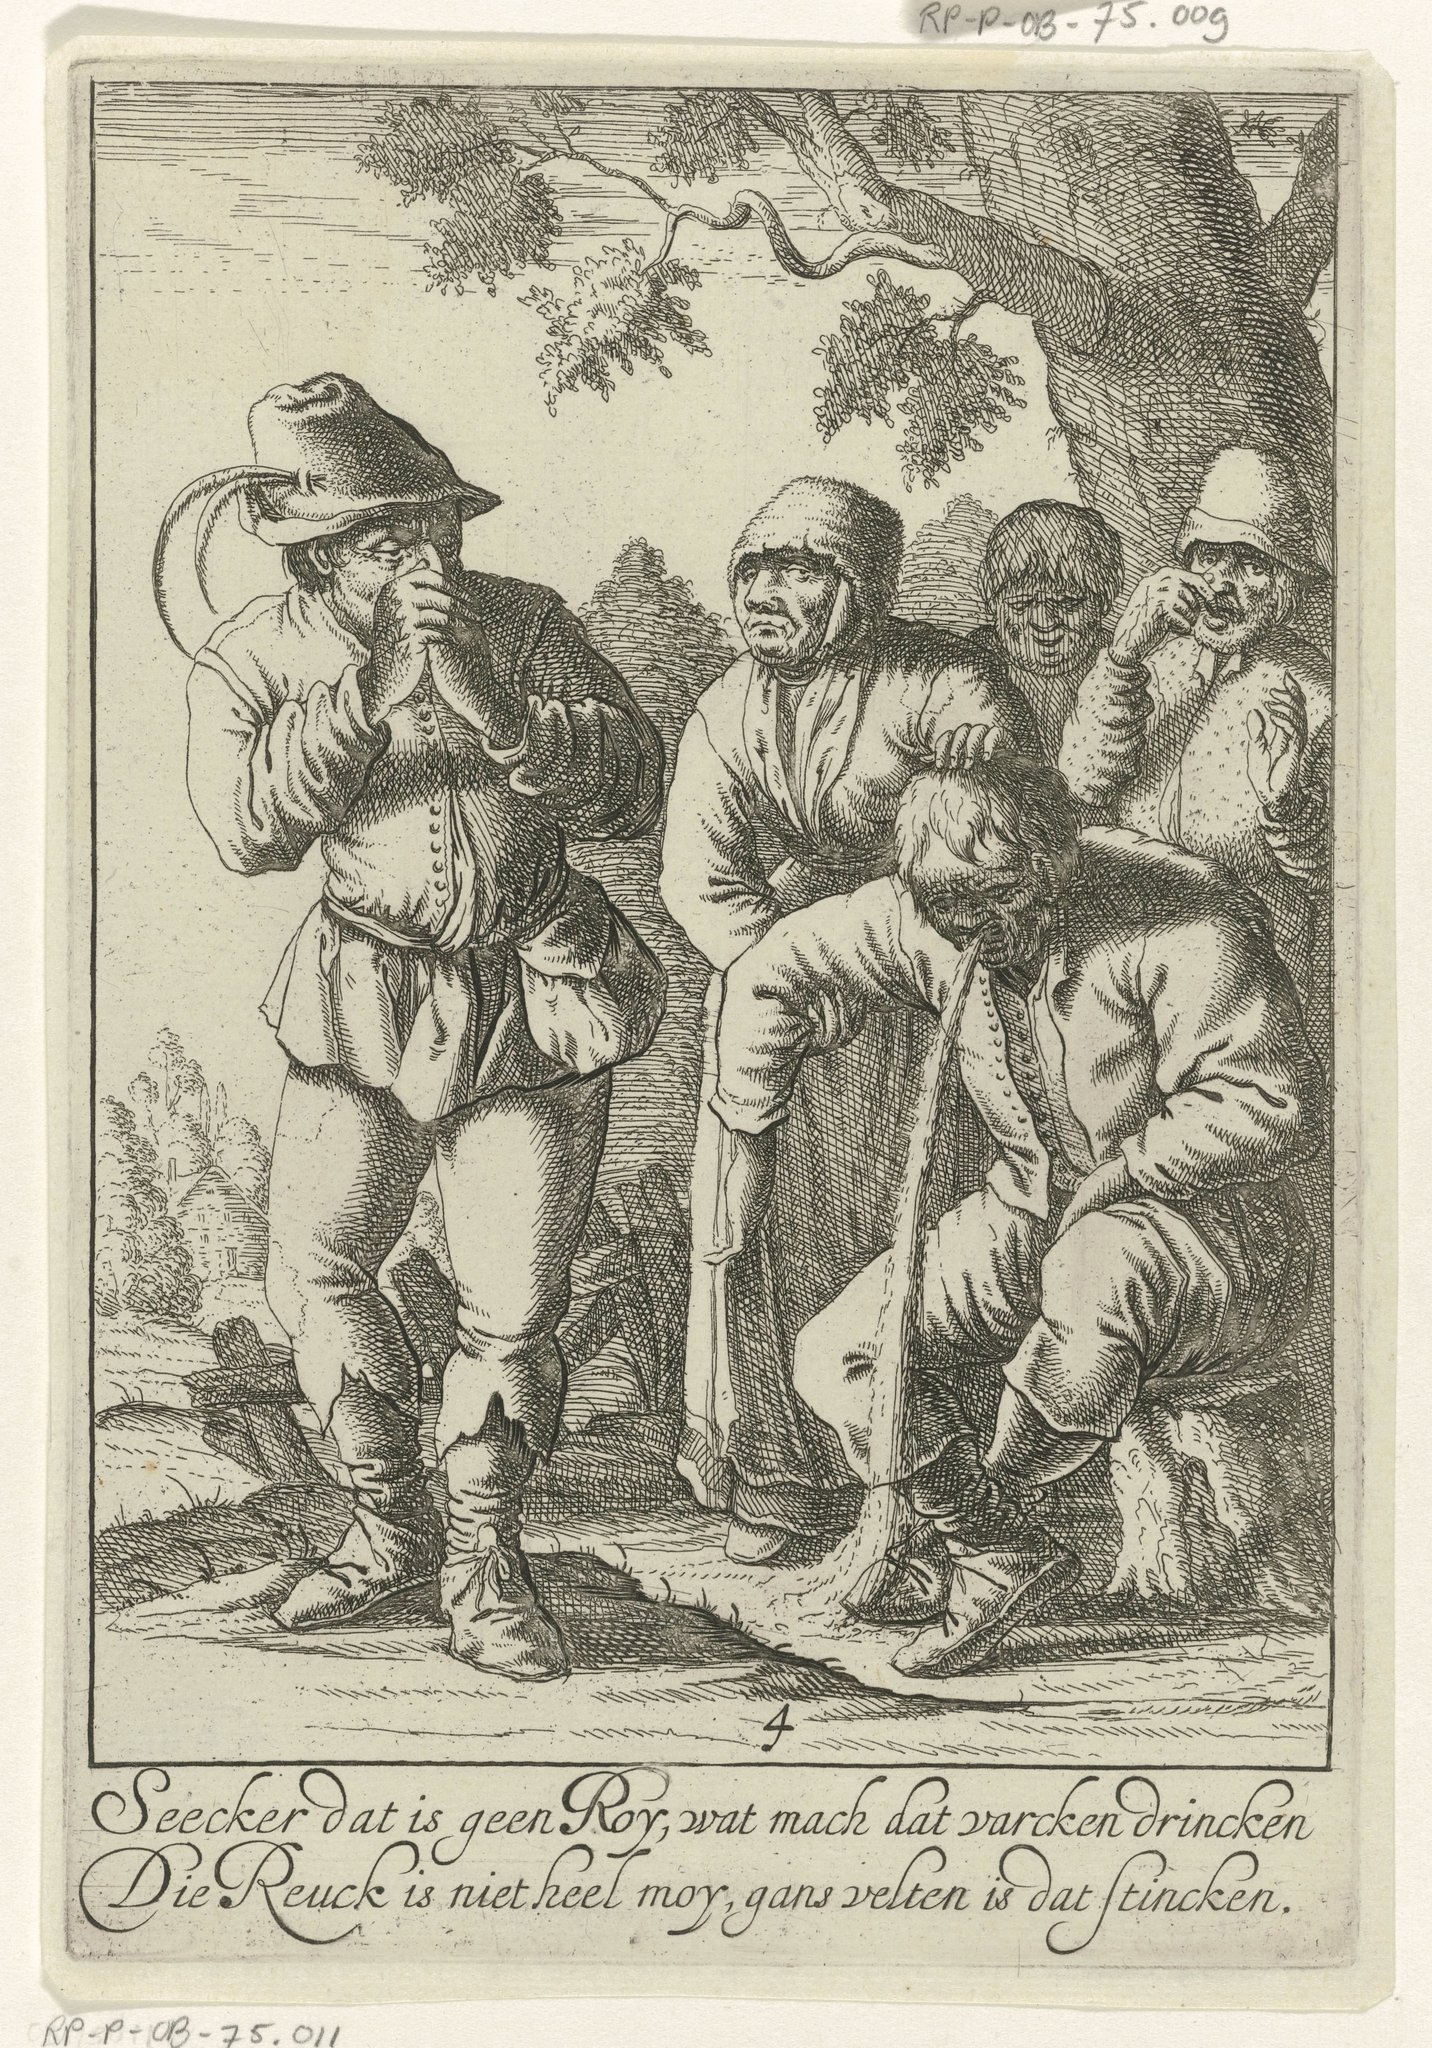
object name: print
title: De vijf zintuigen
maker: clement de jonghe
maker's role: print maker, publisher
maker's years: 1624-1677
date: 1620-1670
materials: paper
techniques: etching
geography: amsterdam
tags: disagreeable, repellent smell, drunkard, vomiting, smell, smelling (one of the five senses)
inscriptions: collector's mark: Lugt 2228, number: ‘4’, caption: ‘Seecker dat is geen Roy, wat mach dat varcken drincken / Die Reuck is niet heel moy, gans velten is dat stincken.’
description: Een man geeft over. Twee mannen knijpen hun neus dicht, omdat de kots stinkt. Onder de voorstelling een tweeregelig vers in het Nederlands. De prent maakt deel uit van een serie van vijf prenten met de vijf zintuigen.